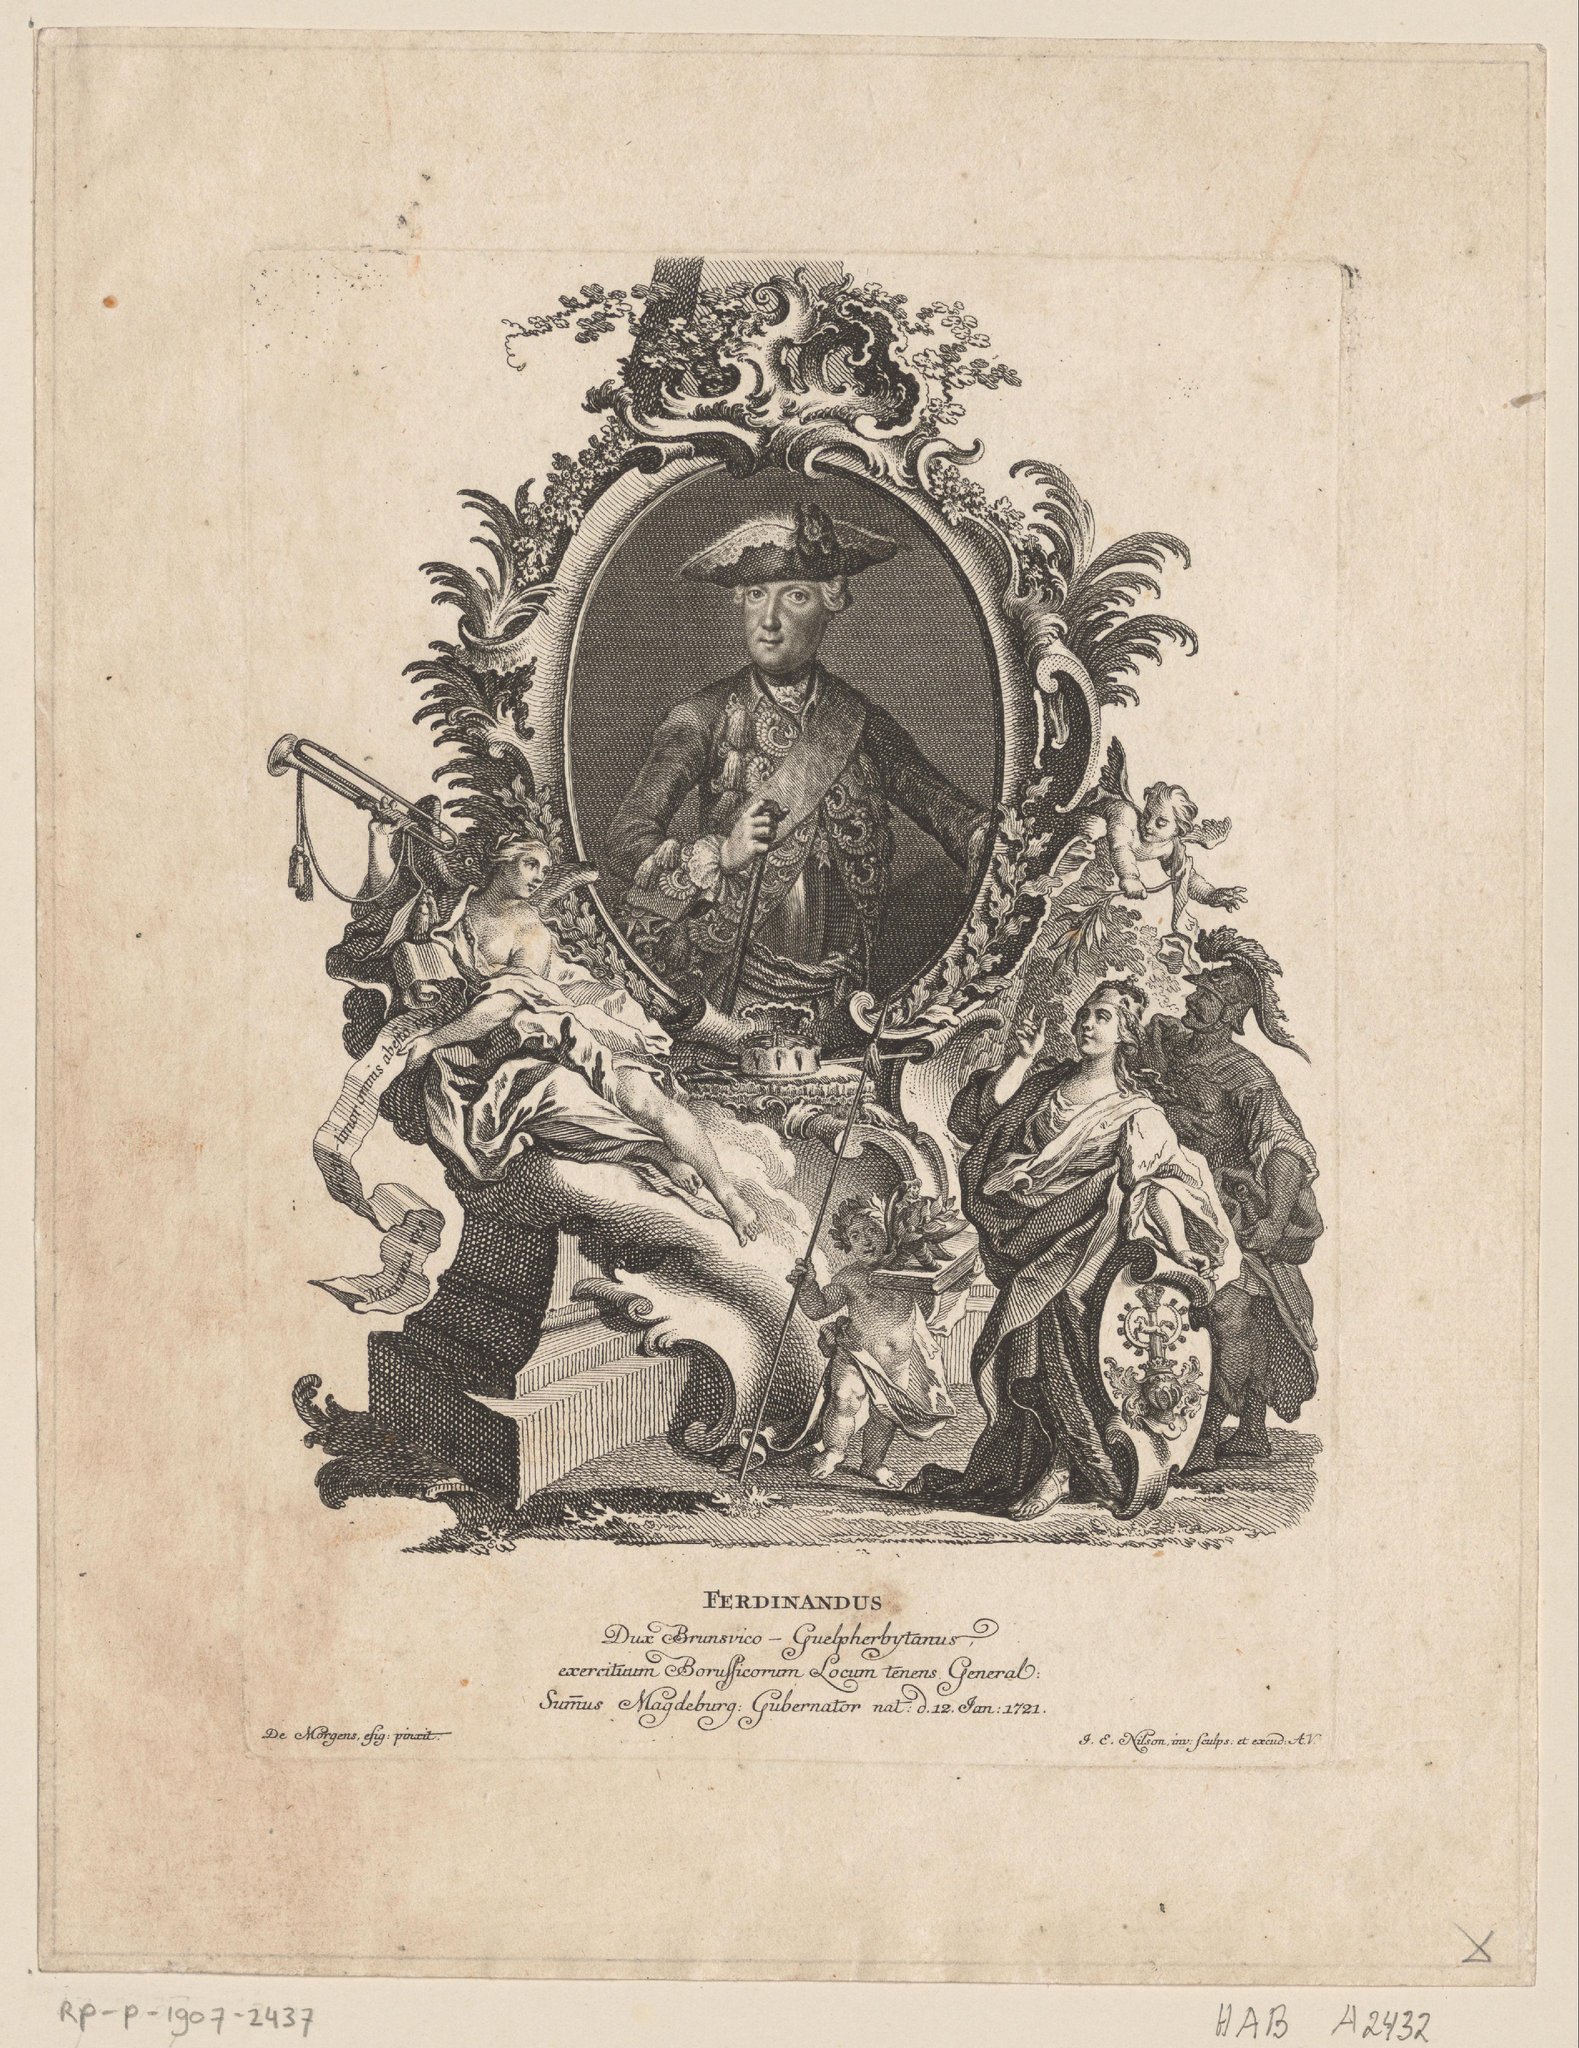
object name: print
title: Portret van Ferdinand van Brunswijk-Wolfenbüttel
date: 1752-1788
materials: paper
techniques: etching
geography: augsburg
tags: armour, historical persons, fame; 'fama', 'fama buona', 'fama chiara' (ripa), cupids: 'amores', 'amoretti', 'putti', armorial bearing, heraldry